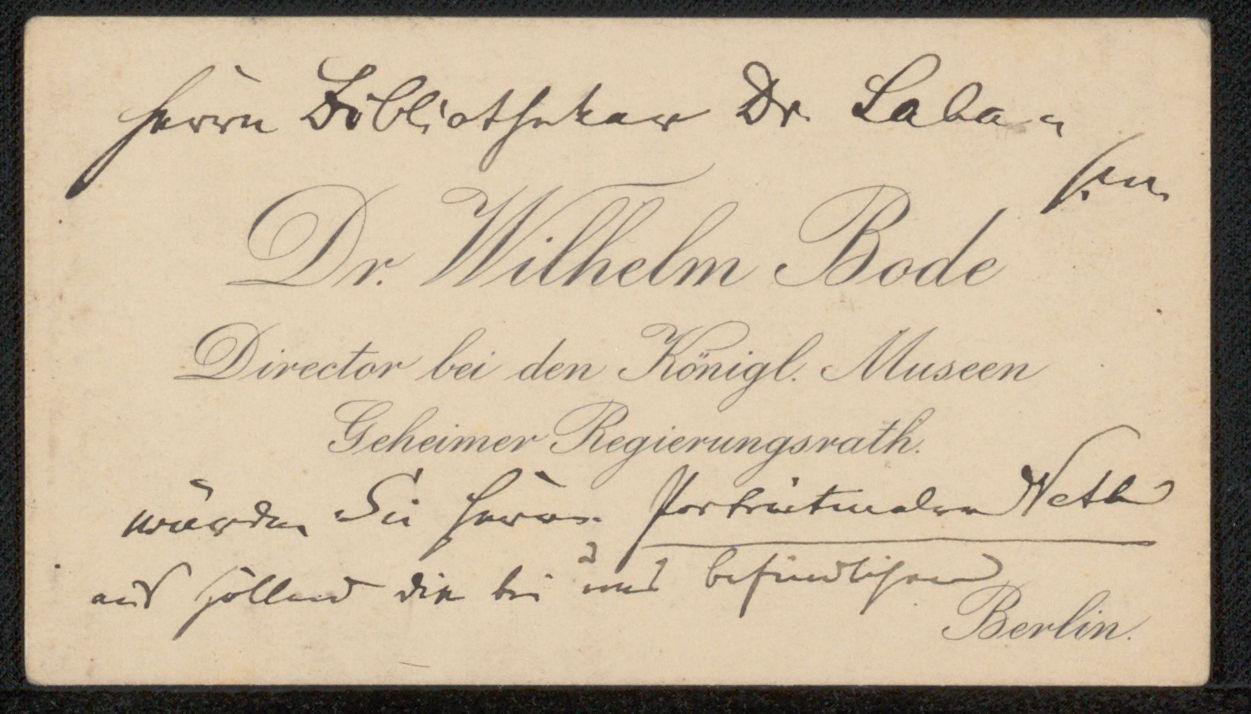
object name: visiting card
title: Visitekaartje aan Ferdinand Emmerich Karl Laban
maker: wilhelm von bode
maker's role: conservator, kunsthistoricus, museumdirecteur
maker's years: 1845-1929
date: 1874-1925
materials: cardboard, ink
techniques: pen, printing, writing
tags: dordrecht, painter, print maker, draughtsman, designer, jan veth, anonymous historical person portrayed, painting (including book-illumination, miniature-painting)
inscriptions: collector's mark: ‘RPK’